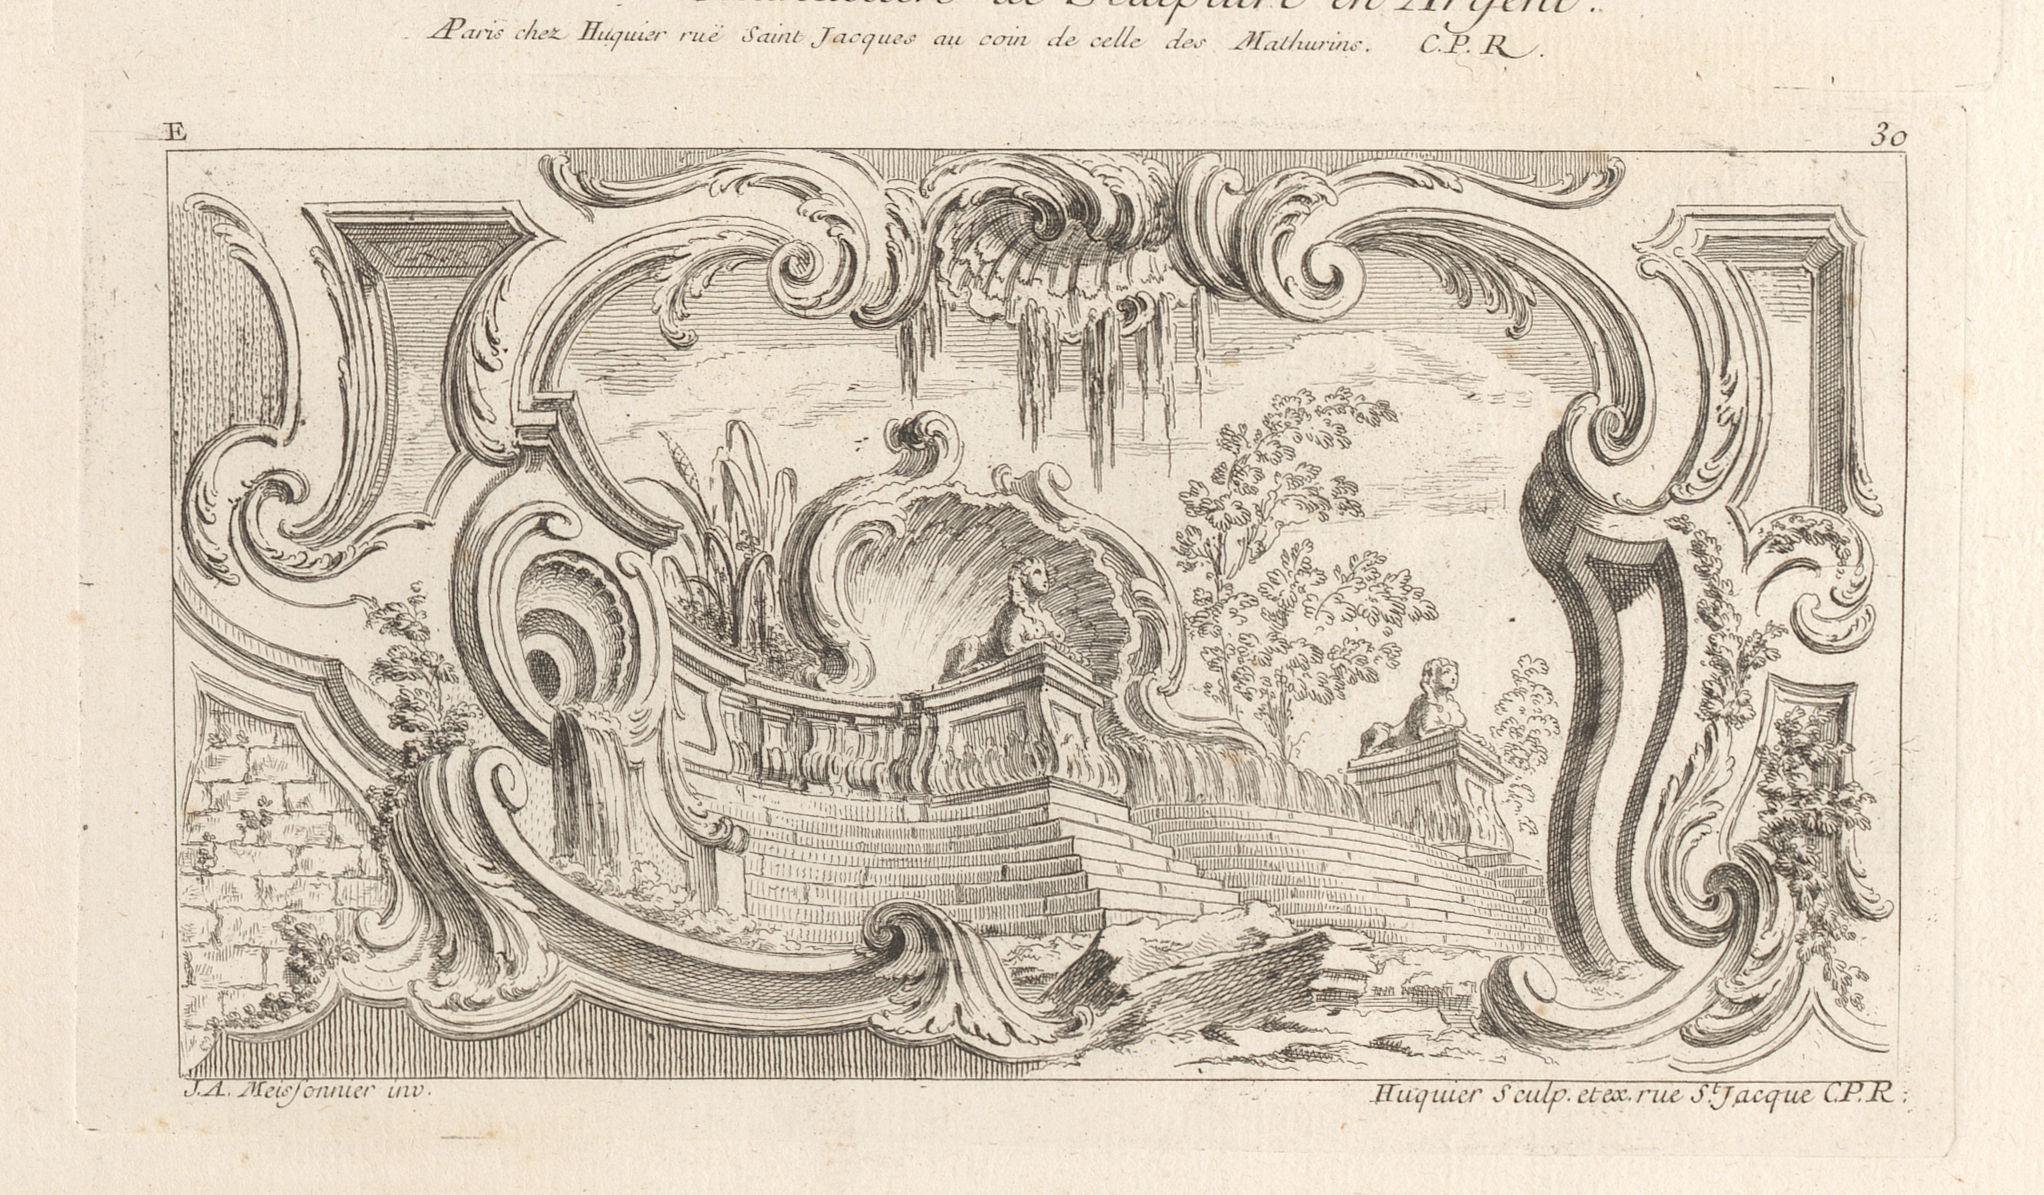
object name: print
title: Ornament met trappen naar een terras waarop twee sfinxen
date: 1738-1749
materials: paper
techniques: etching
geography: paris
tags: rocaille ornament, sphinx (lion/woman); 'sfinge' (ripa)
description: Deze prent maakt deel uit van de serie "Cinquieme livre d'ornemens inventés par J.A. Meissonnier", een van de delen van de monumentale reeks "Oeuvre de Juste Aurele Meissonnier".